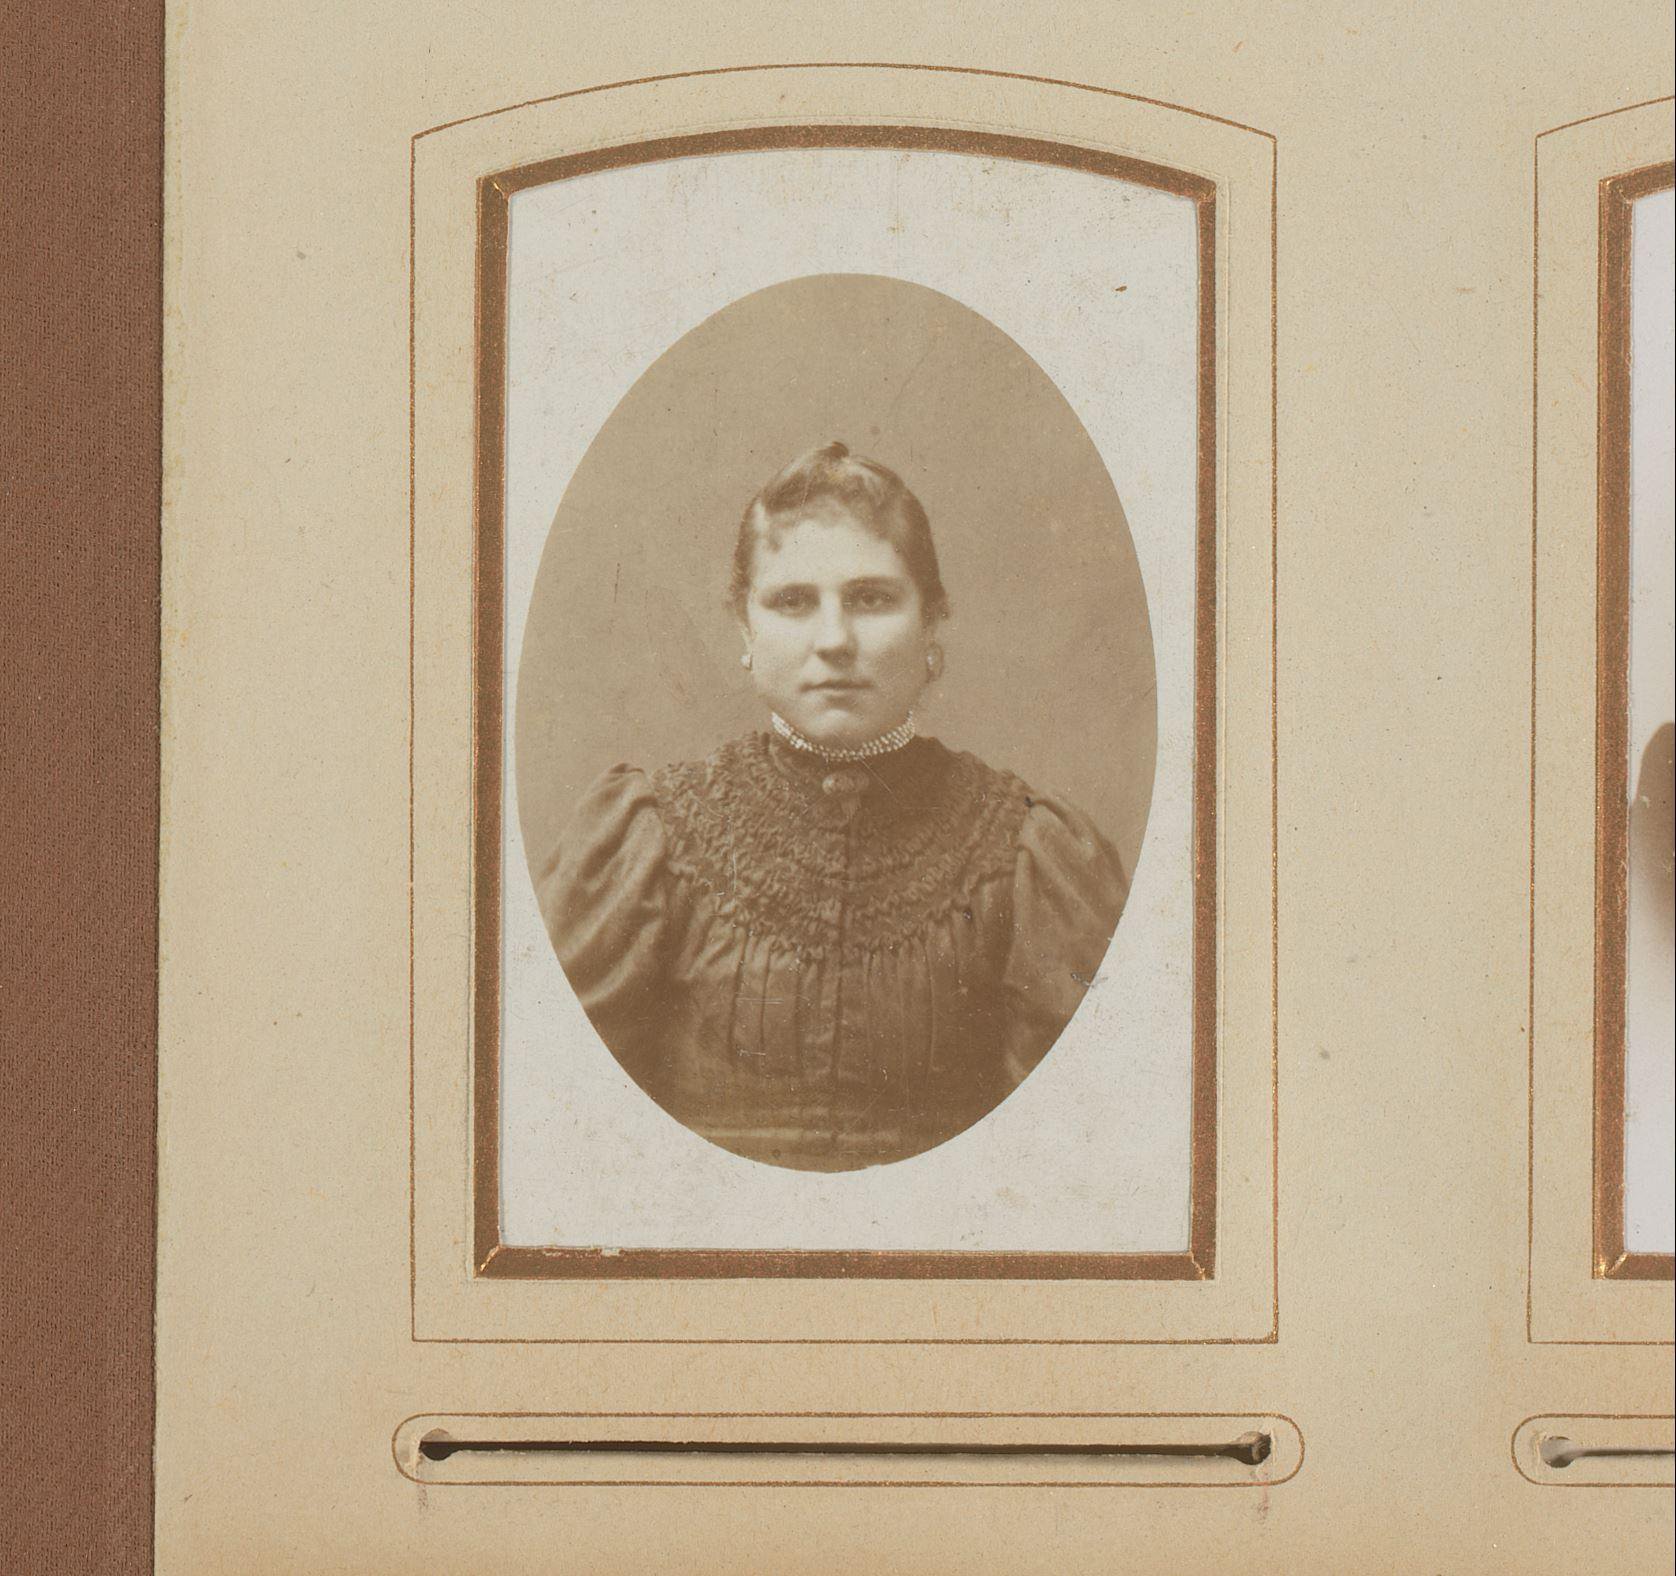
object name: album leaf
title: Portret van een vrouw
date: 1880-1920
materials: cardboard, photographic support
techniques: collodion silver print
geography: amsterdam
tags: historical persons - bb - woman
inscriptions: inscription: ‘Entrée/ Melksalon/ Photographie/ ,,De Concurrent"/ Nieuwendyk 137,/ 4e huis van de Oudebrugsteeg/ Amsterdam.’